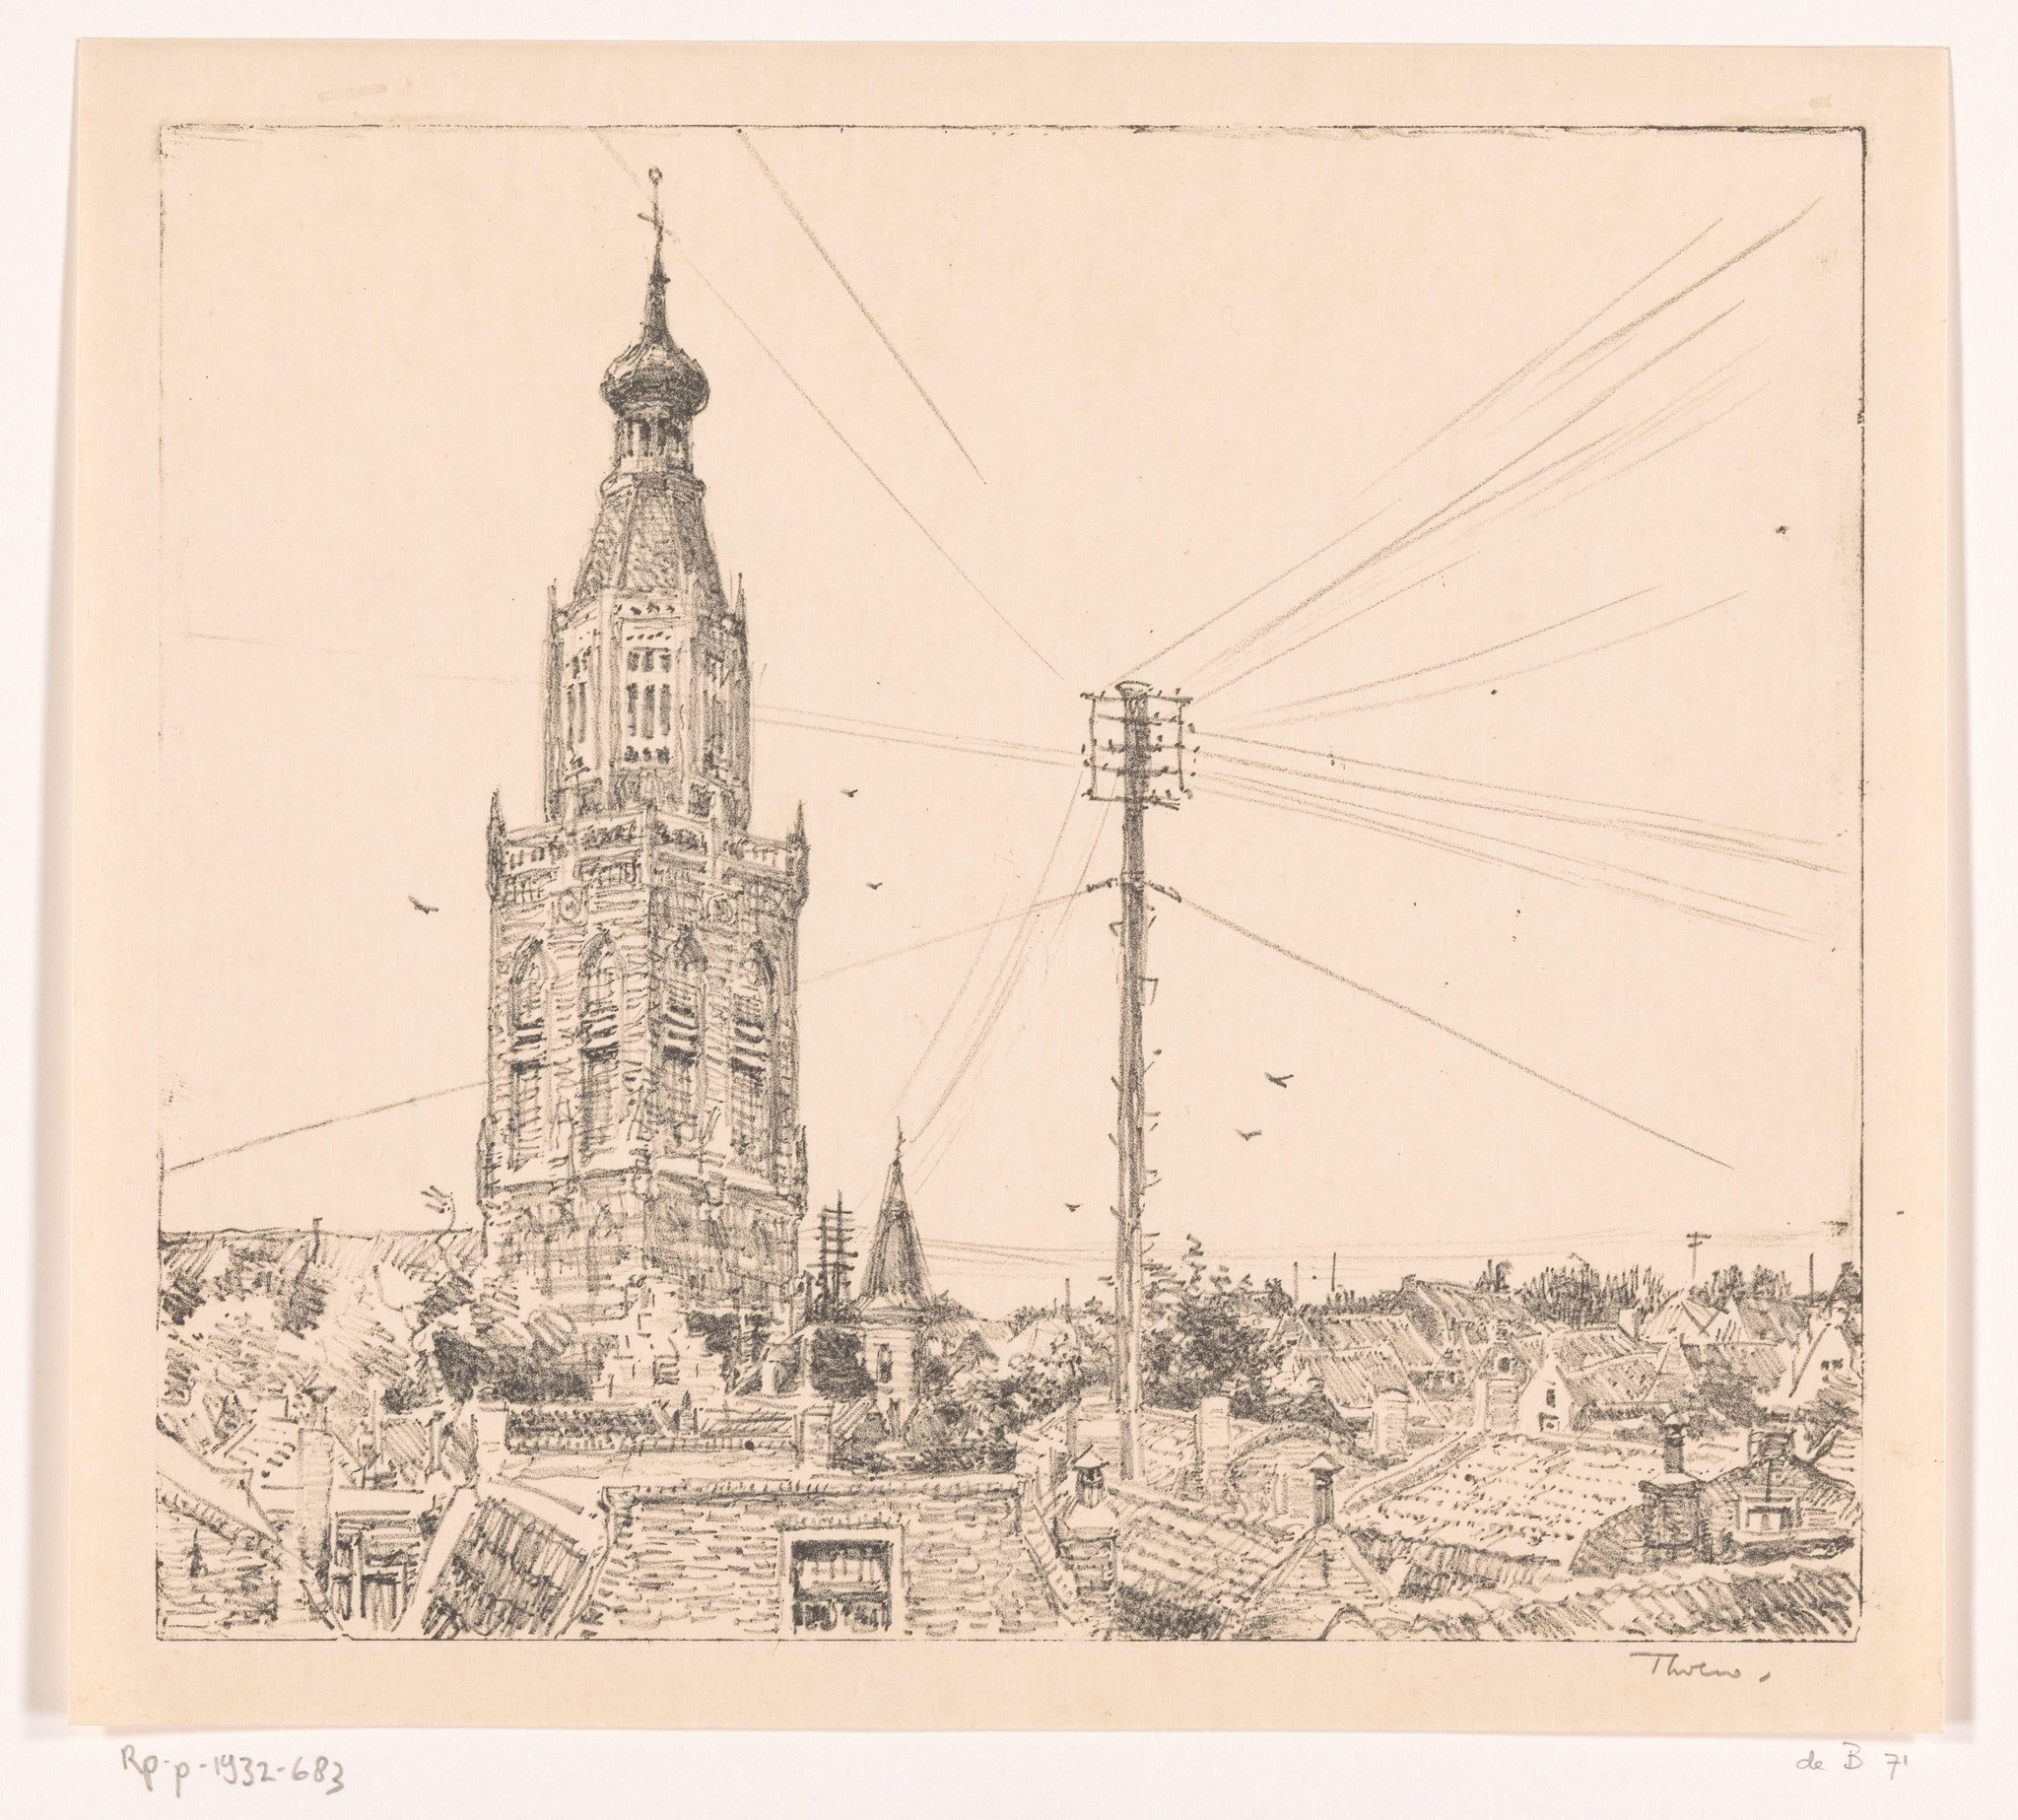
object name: print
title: Gezicht op de toren van de Zuiderkerk, te Enkhuizen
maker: willem bastiaan tholen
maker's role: draughtsman, painter, print maker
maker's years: 1860-1931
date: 1870-1931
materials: paper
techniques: lithograph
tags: telegraph pole, telephone pole, parts of church exterior and annexes: tower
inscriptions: collector's mark: Lugt 2228